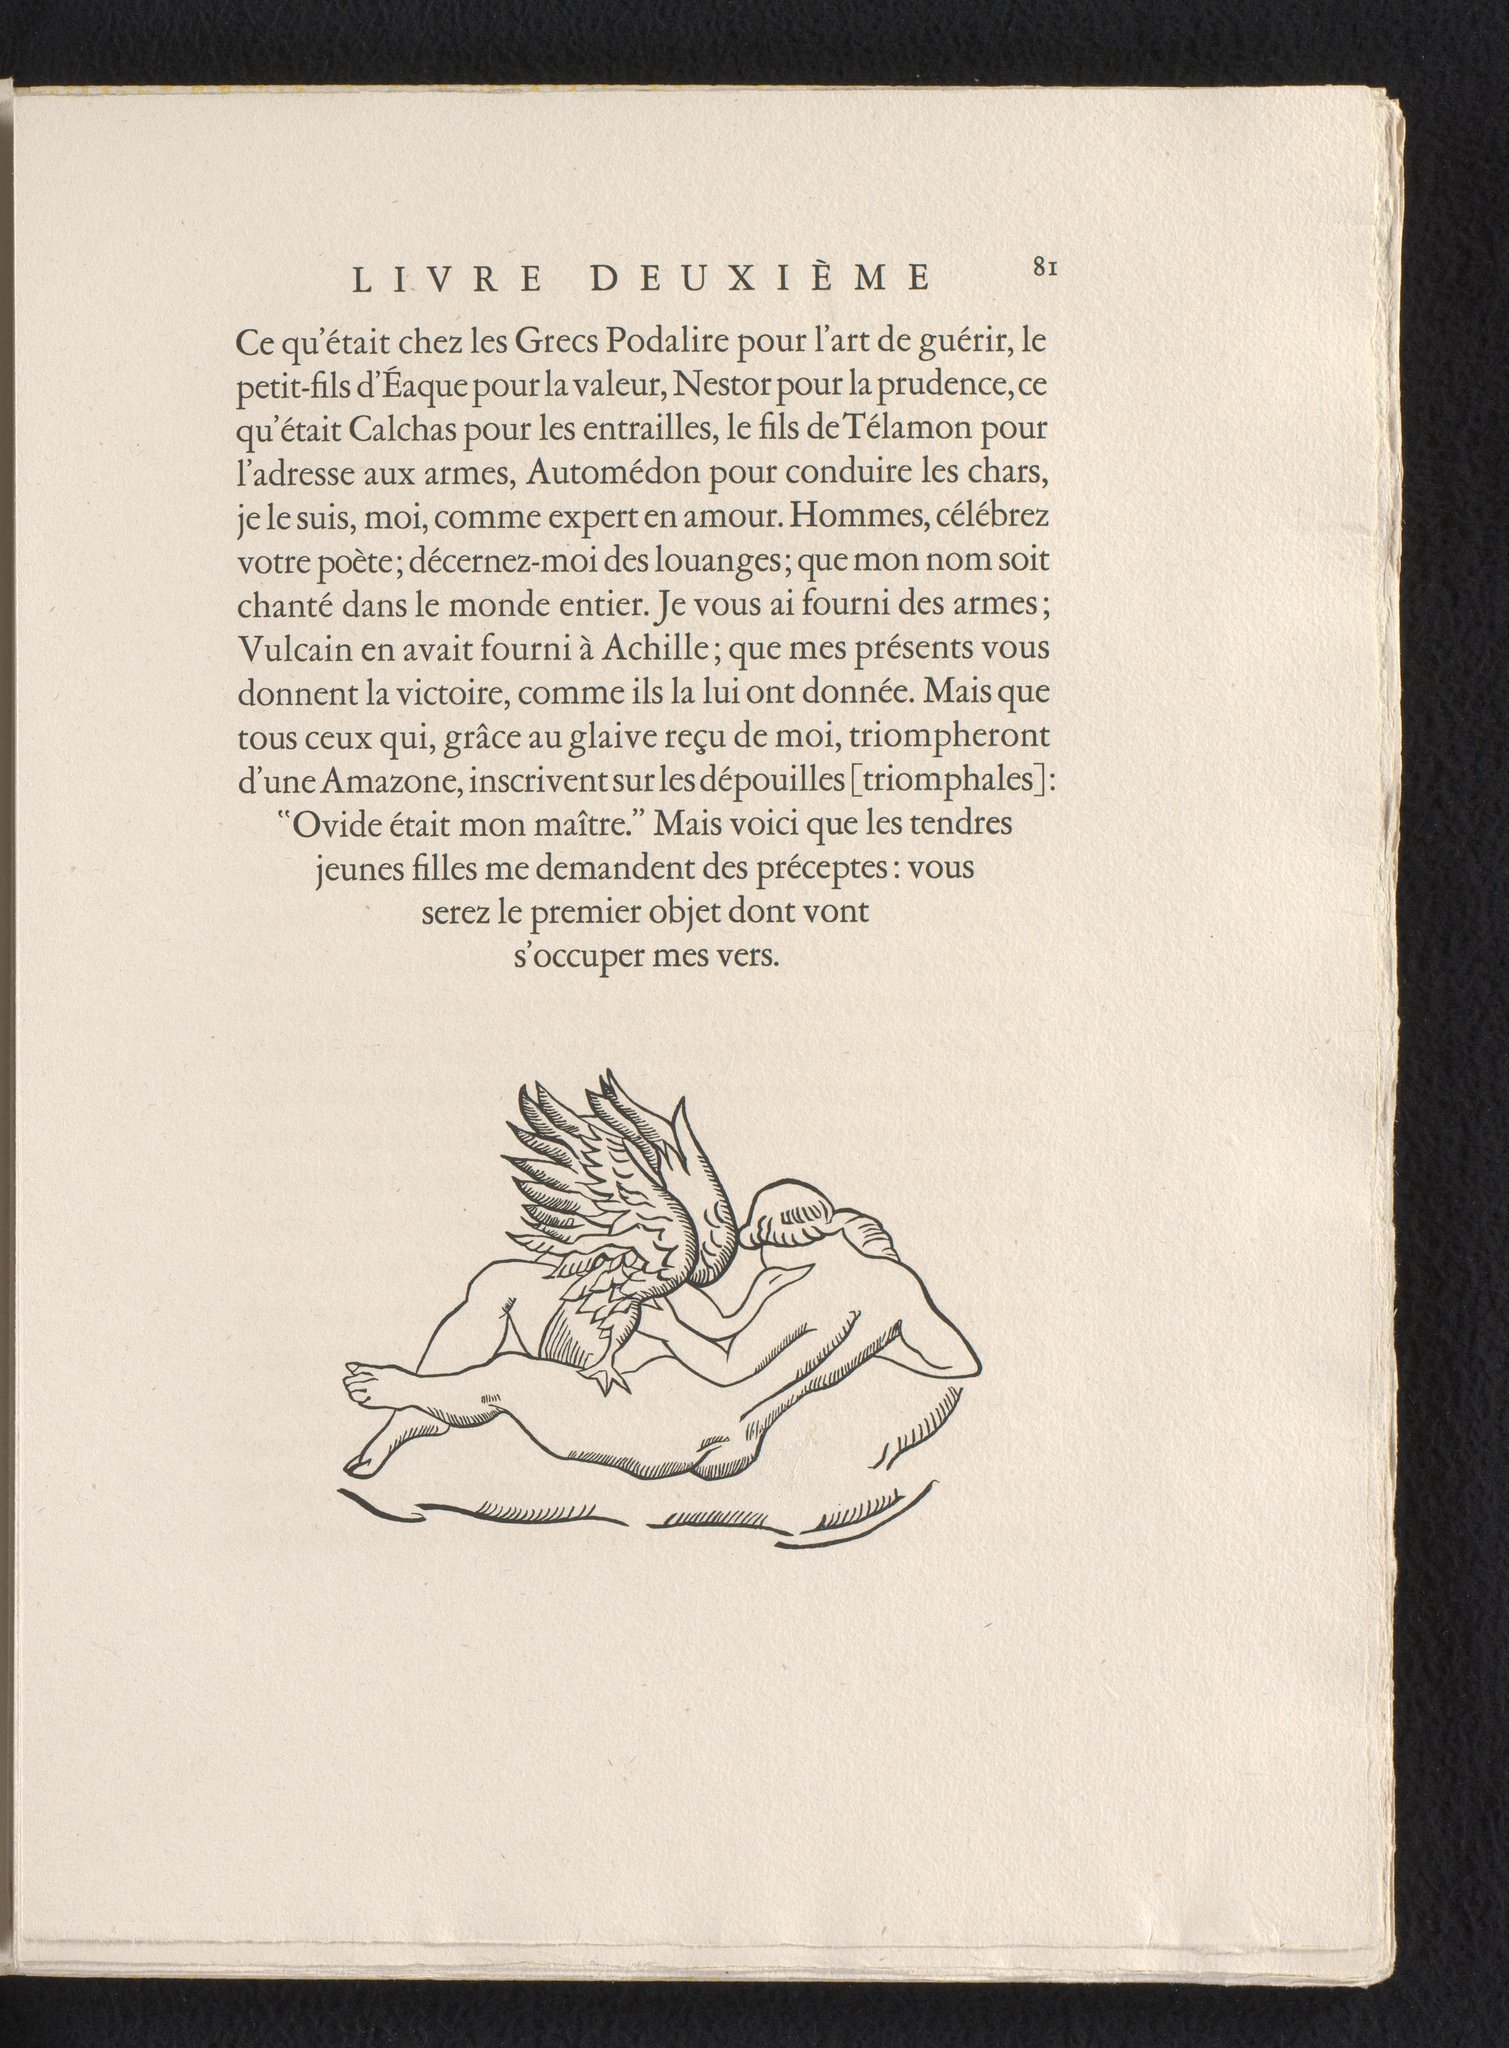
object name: page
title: Leda en de zwaan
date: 1935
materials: paper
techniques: letterpress printing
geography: lausanne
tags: jupiter, in the shape of a swan, and leda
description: Prent in: Ovidius Naso, Publius. L'art d'aimer. [Vertaald uit het Latijn door] Henri Bornecque. Parijs/Lausanne: Les frères Gonin, 1935, p. 81.